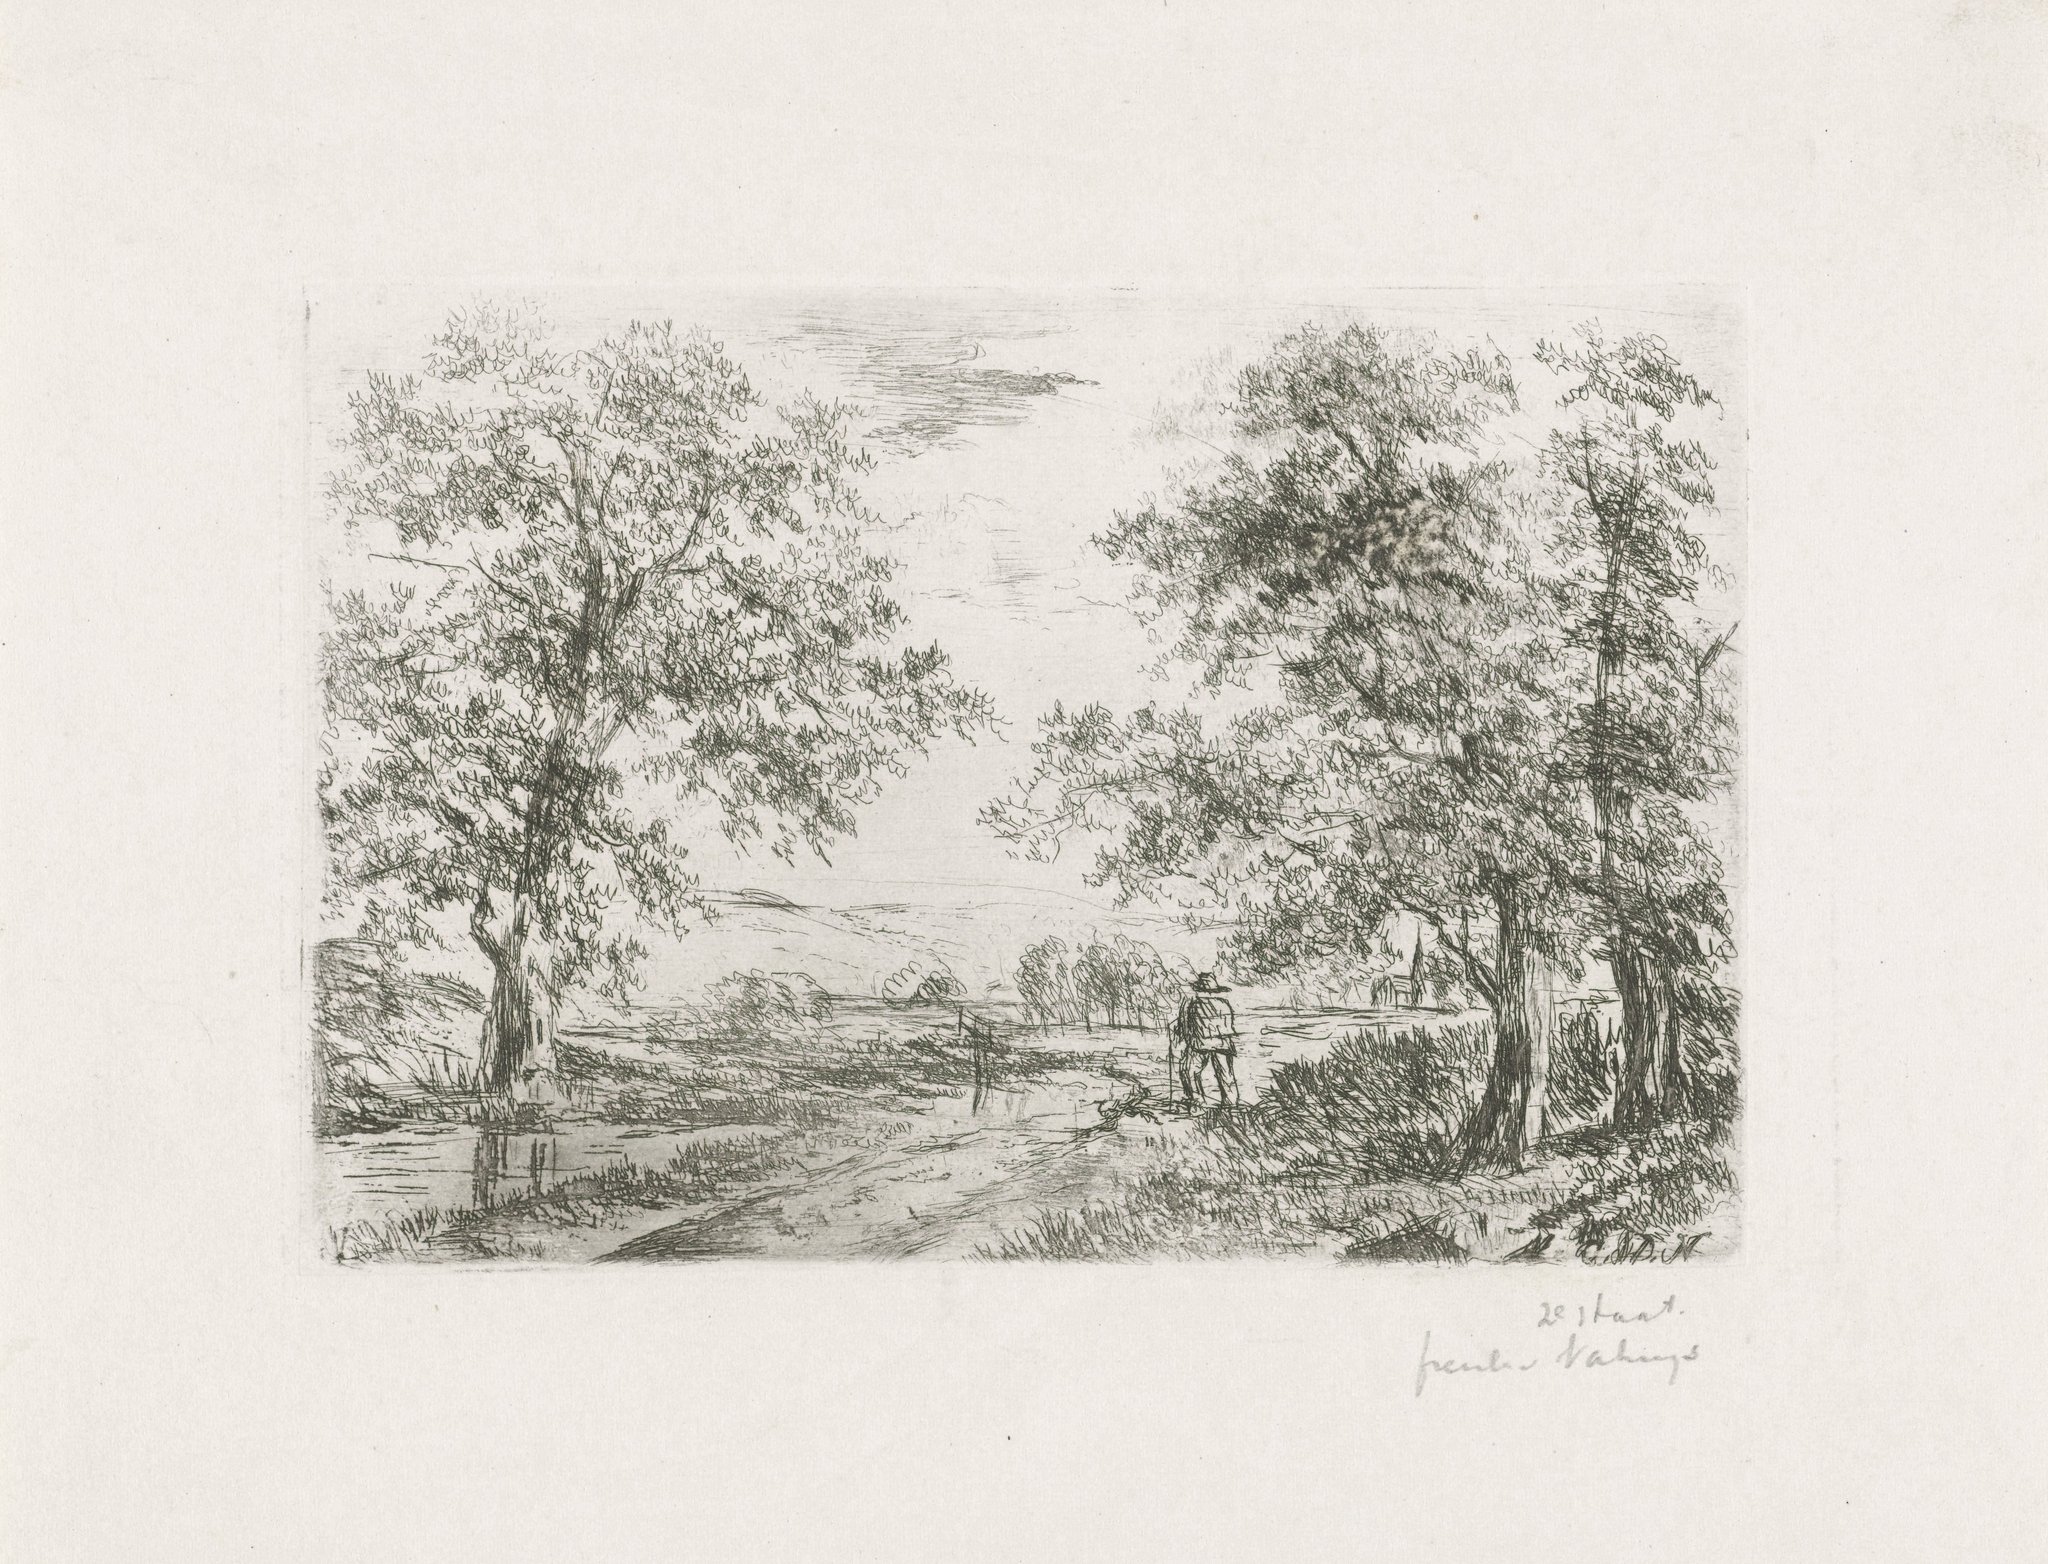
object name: print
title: Landschap met wandelaar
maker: cécile dorothea nahuys-schuil van der does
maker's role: print maker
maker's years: 1800-1866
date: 1810-1866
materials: paper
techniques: etching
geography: utrecht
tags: landscapes (+ landscape with figures, staffage)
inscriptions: collector's mark: Lugt 2228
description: Landschap met een wandelaar, op de rug gezien, op de weg. Links een boom, rechts twee bomen. Aan de horizon een kerk.